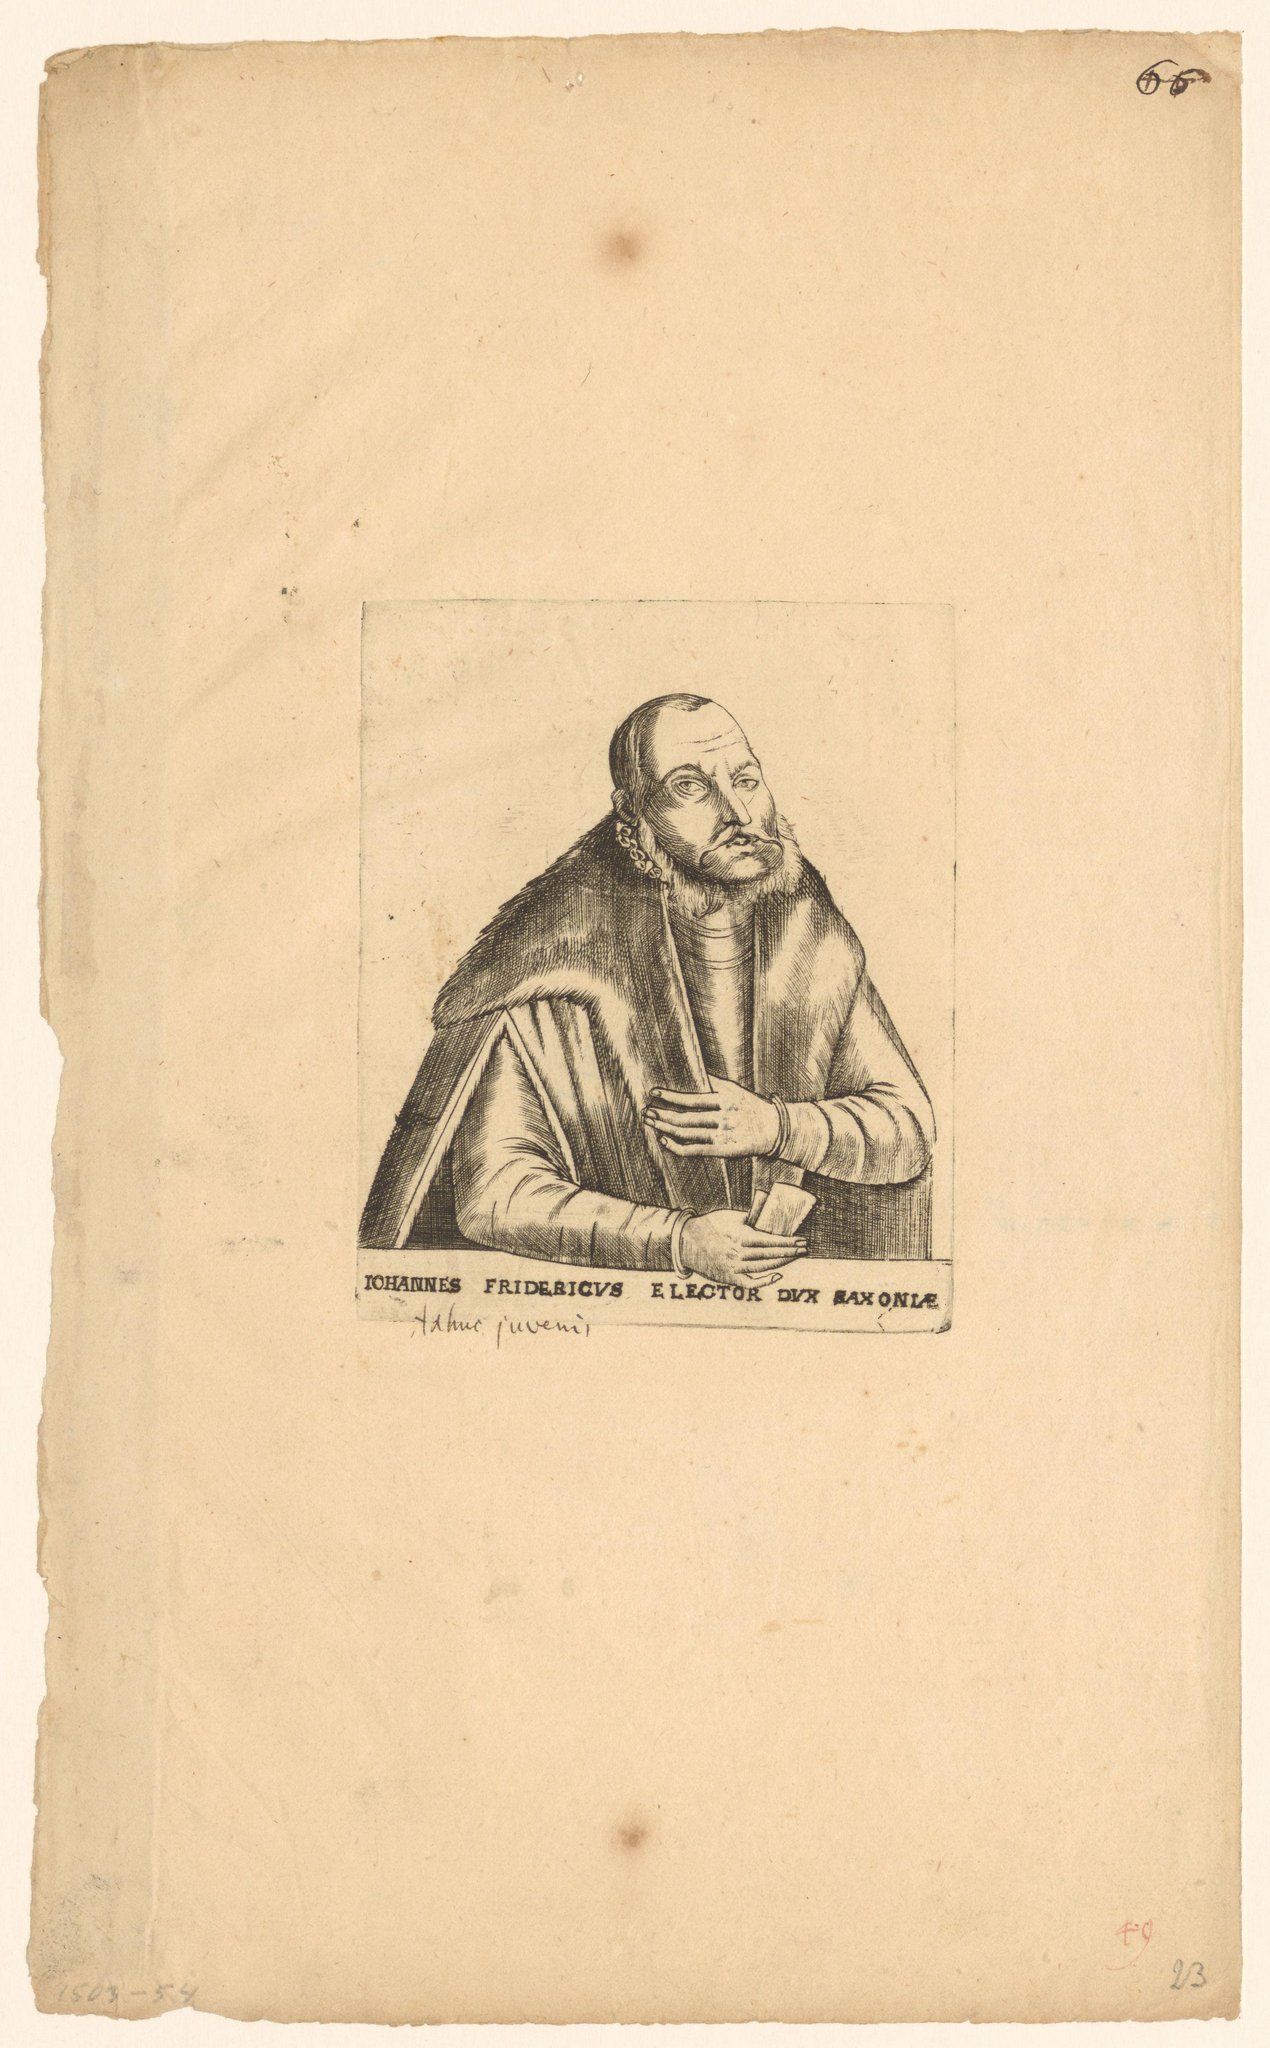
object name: print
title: Portret van Johan Frederik I Saksen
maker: Anonymous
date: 1563-1642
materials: paper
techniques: engraving, etching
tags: historical persons, ruler, sovereign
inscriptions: number: ‘68’, collector's mark: Lugt 2228, number: ‘49’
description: Deze prent is gemaakt naar een prent uit een serie portretten van hertogen en kiesmannen uit Saksen door Balthasar Jenichen (in HG: cat. nr. 238, p.85).